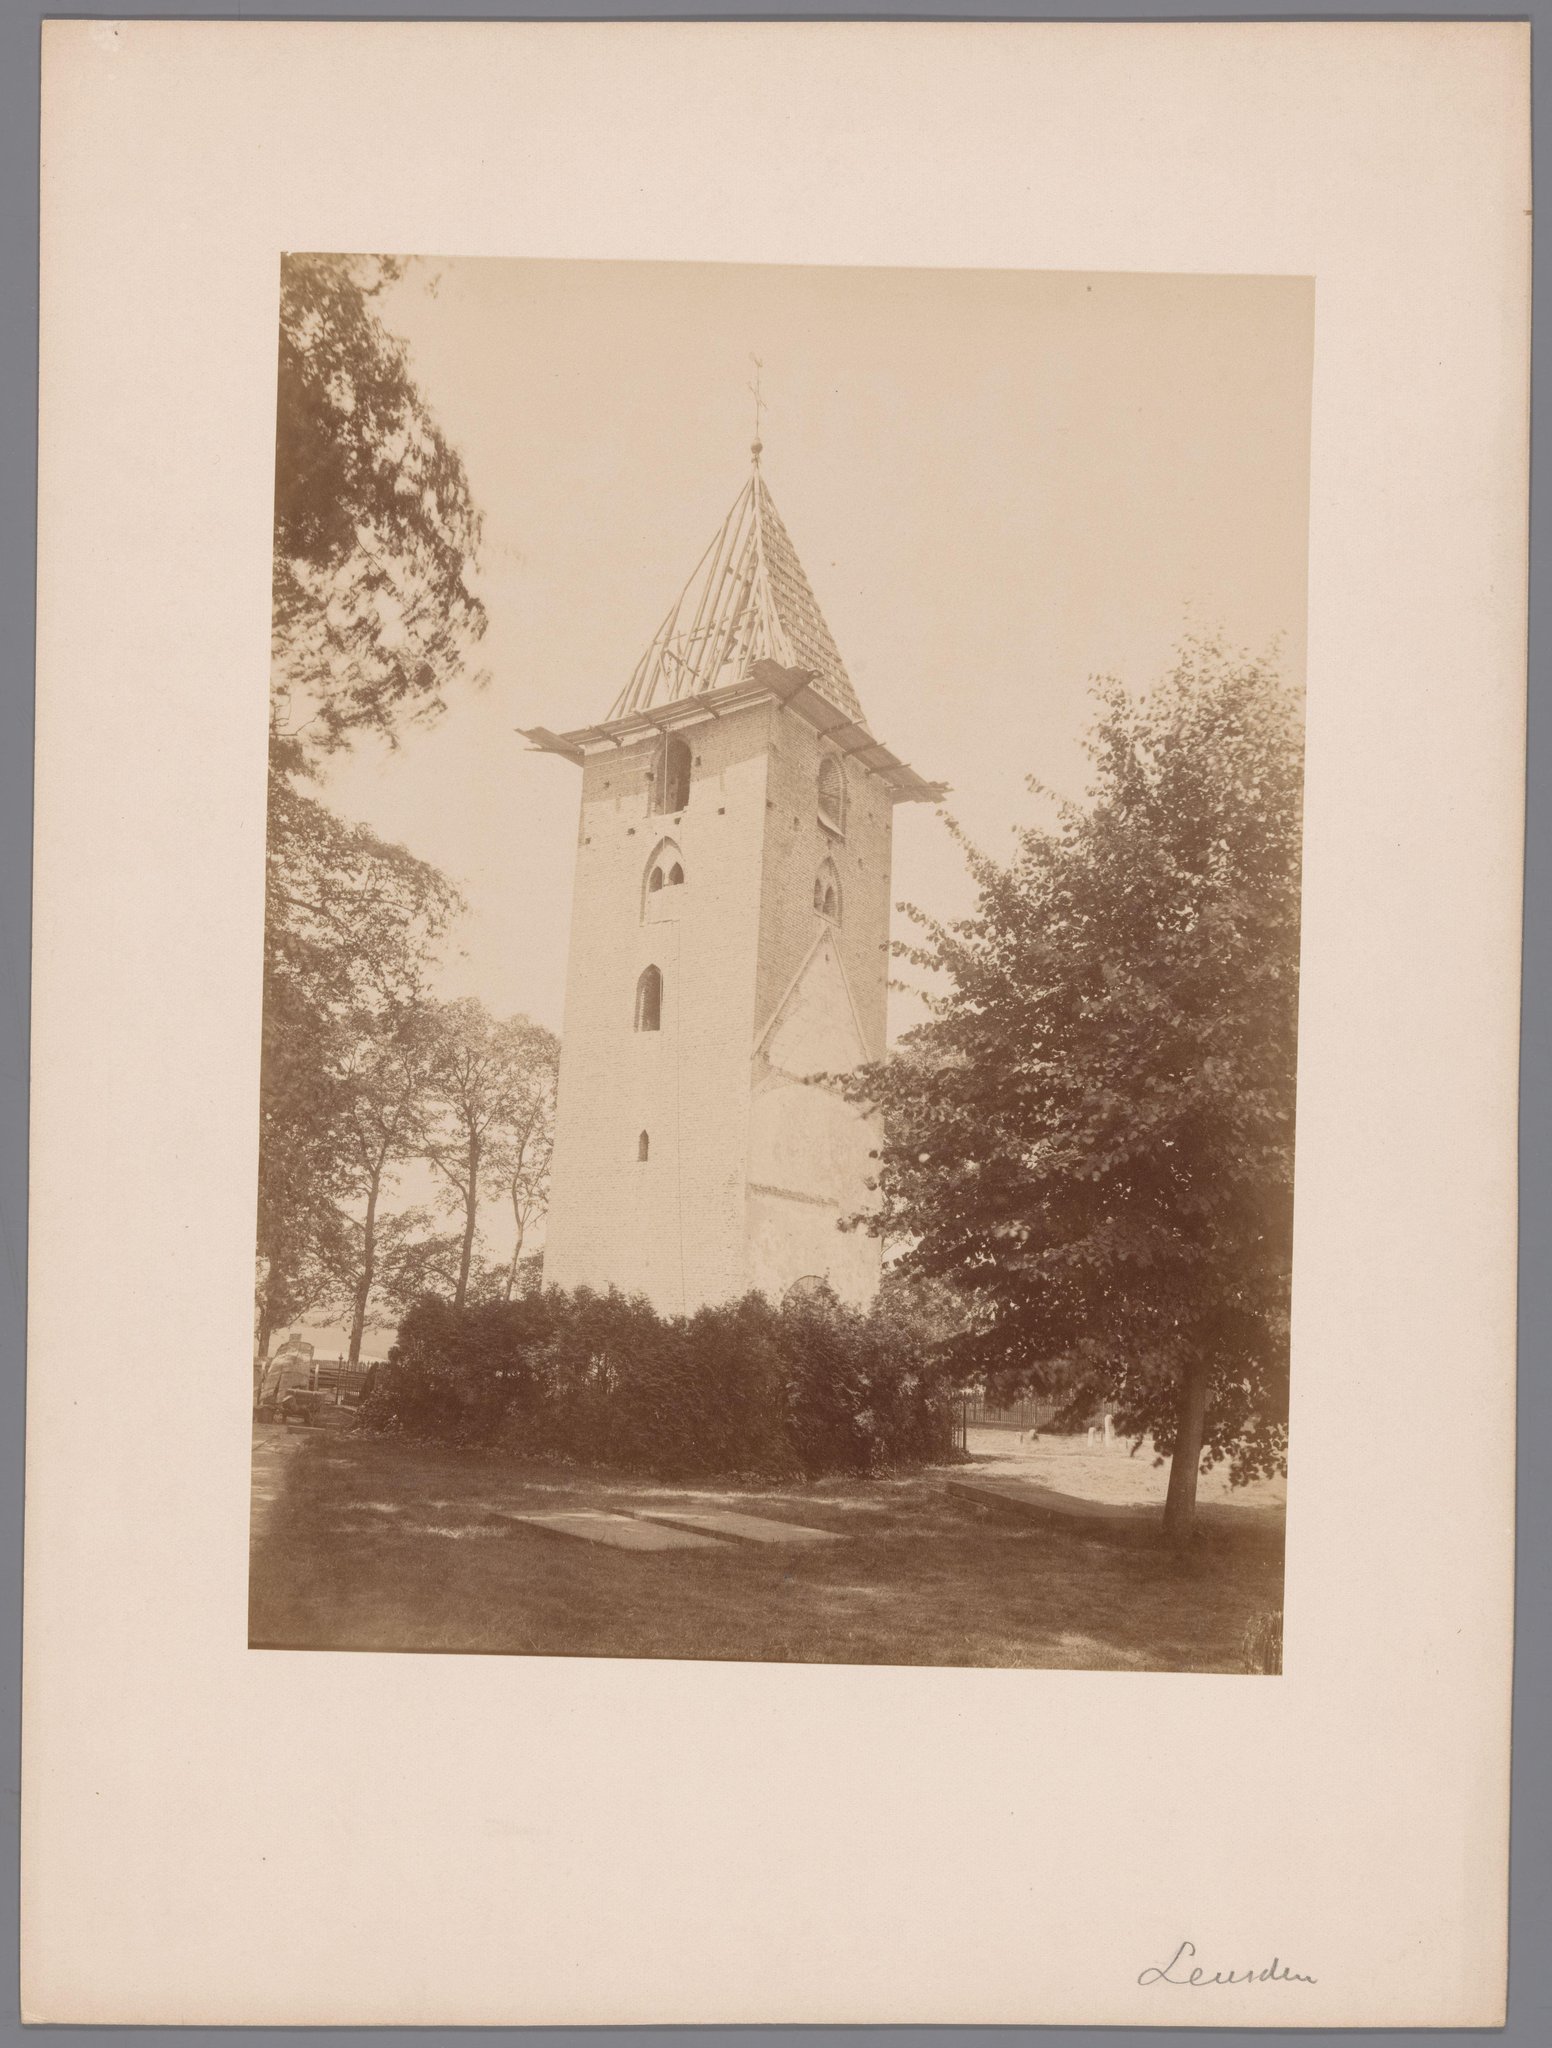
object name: photograph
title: Toren van de Hervormde Kerk te Leusden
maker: anoniem (monumentenzorg)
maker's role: fotograaf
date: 1901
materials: cardboard, photographic support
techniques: albumen print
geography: leusden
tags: parts of church exterior and annexes: tower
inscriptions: annotation: ‘Leusden’, annotation: ‘Leusden bij Amersfoort (U.)/ vrijstaande toren/ juli 1901’